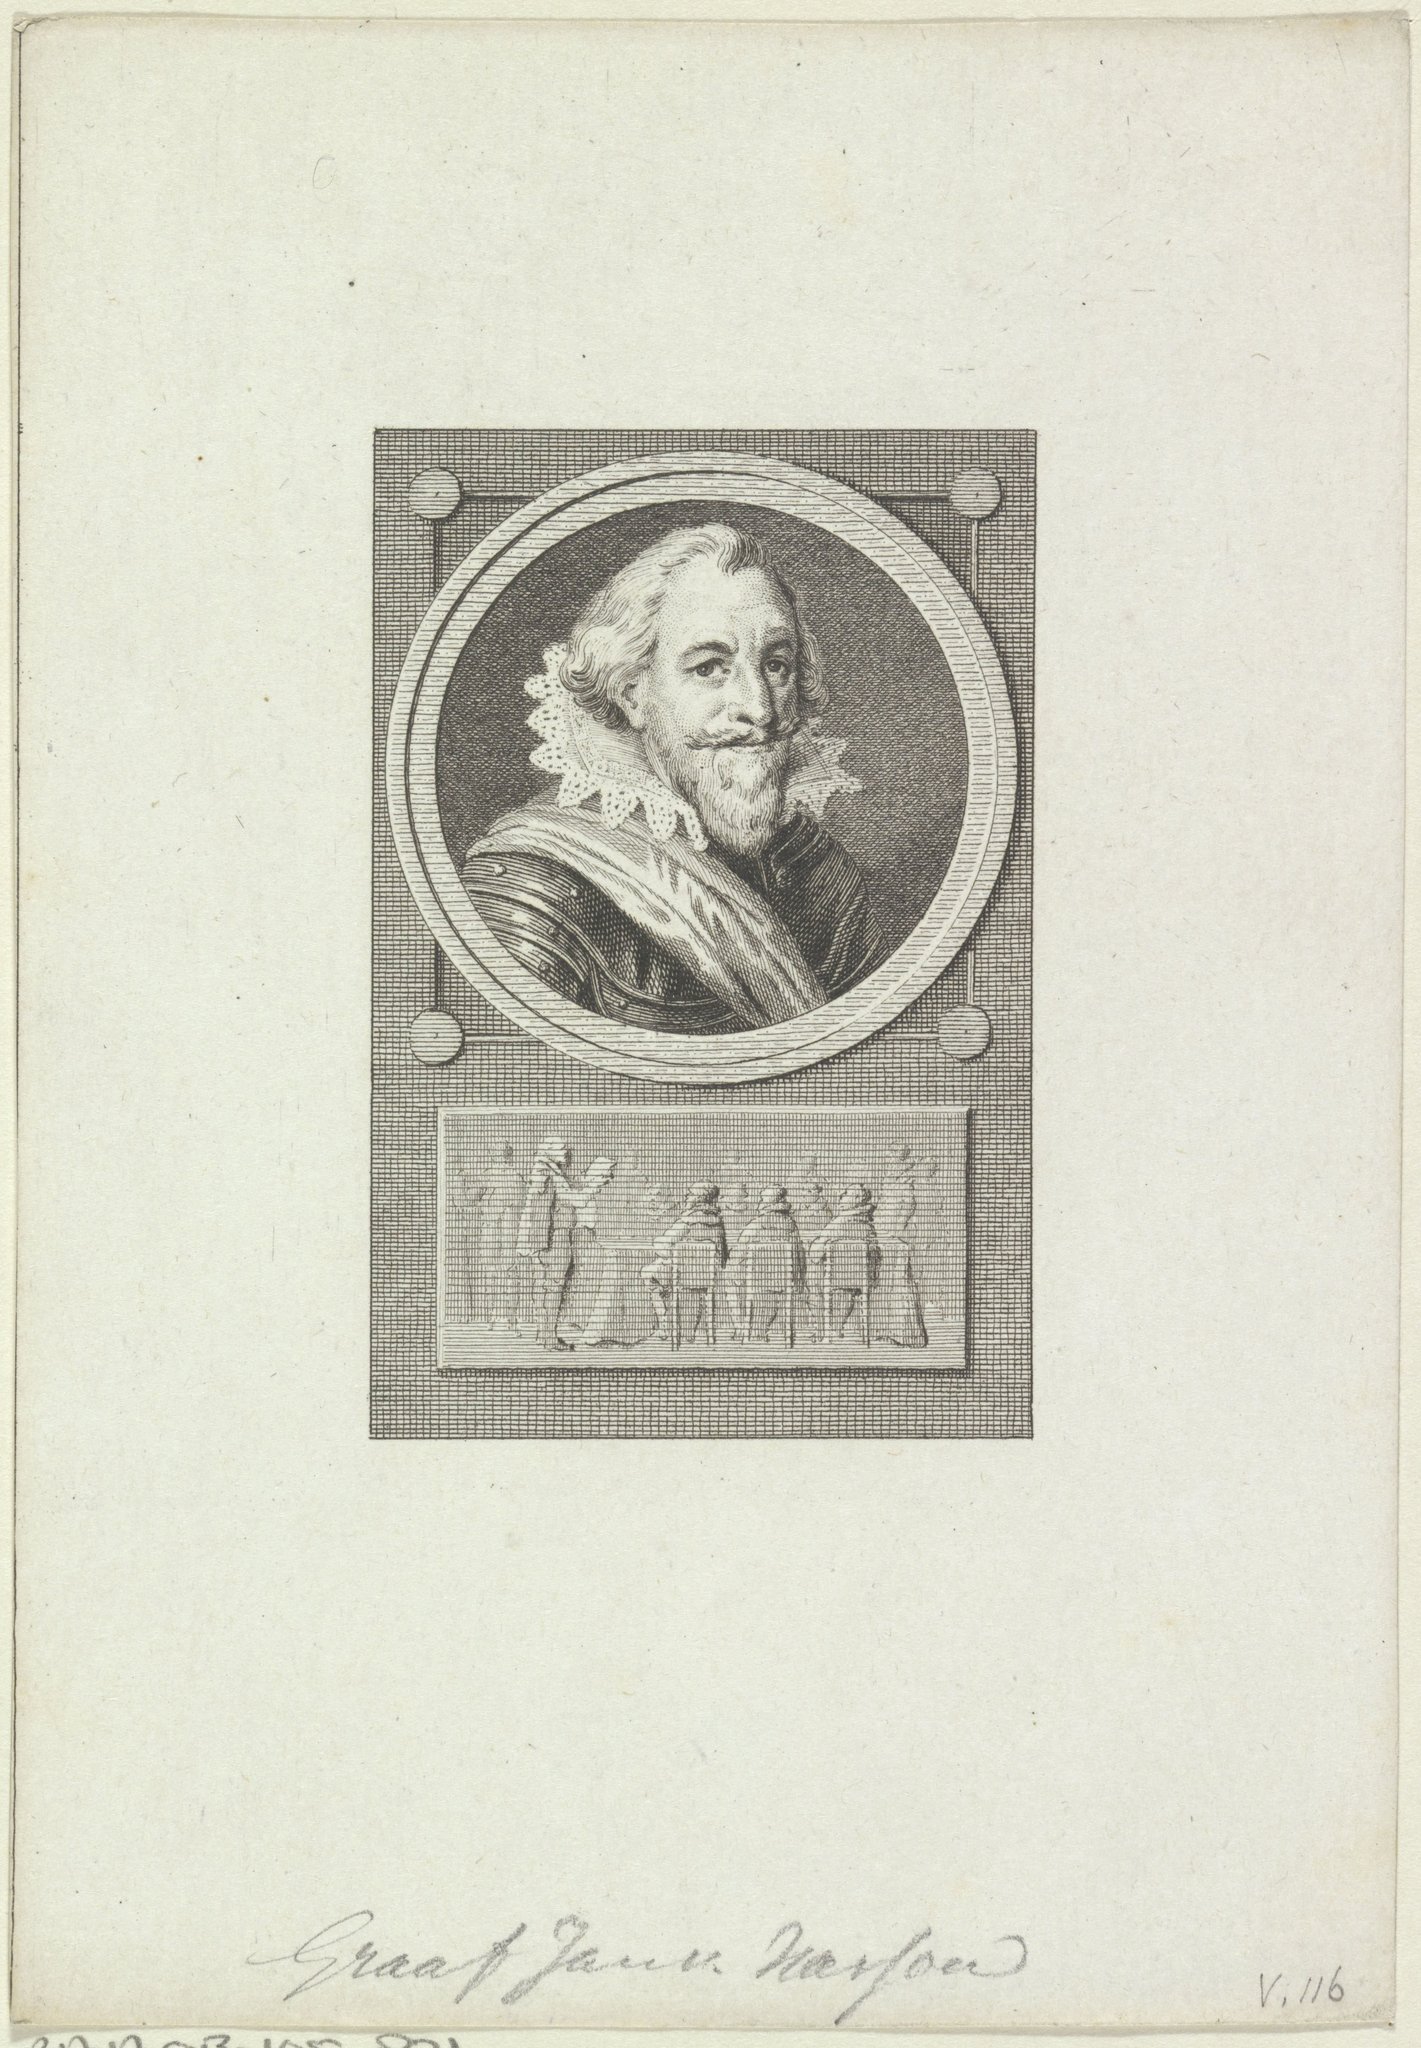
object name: print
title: Portret van Johan VII, graaf van Nassau-Siegen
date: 1771-1816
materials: paper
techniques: engraving, etching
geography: amsterdam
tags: dillenburg, johan vii graaf van nassau-siegen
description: De hier vermelde titel verwijst naar de hoogst verkregen titel van de geportretteerde, niet per se naar de titel die de geportretteerde op deze voorstelling draagt.